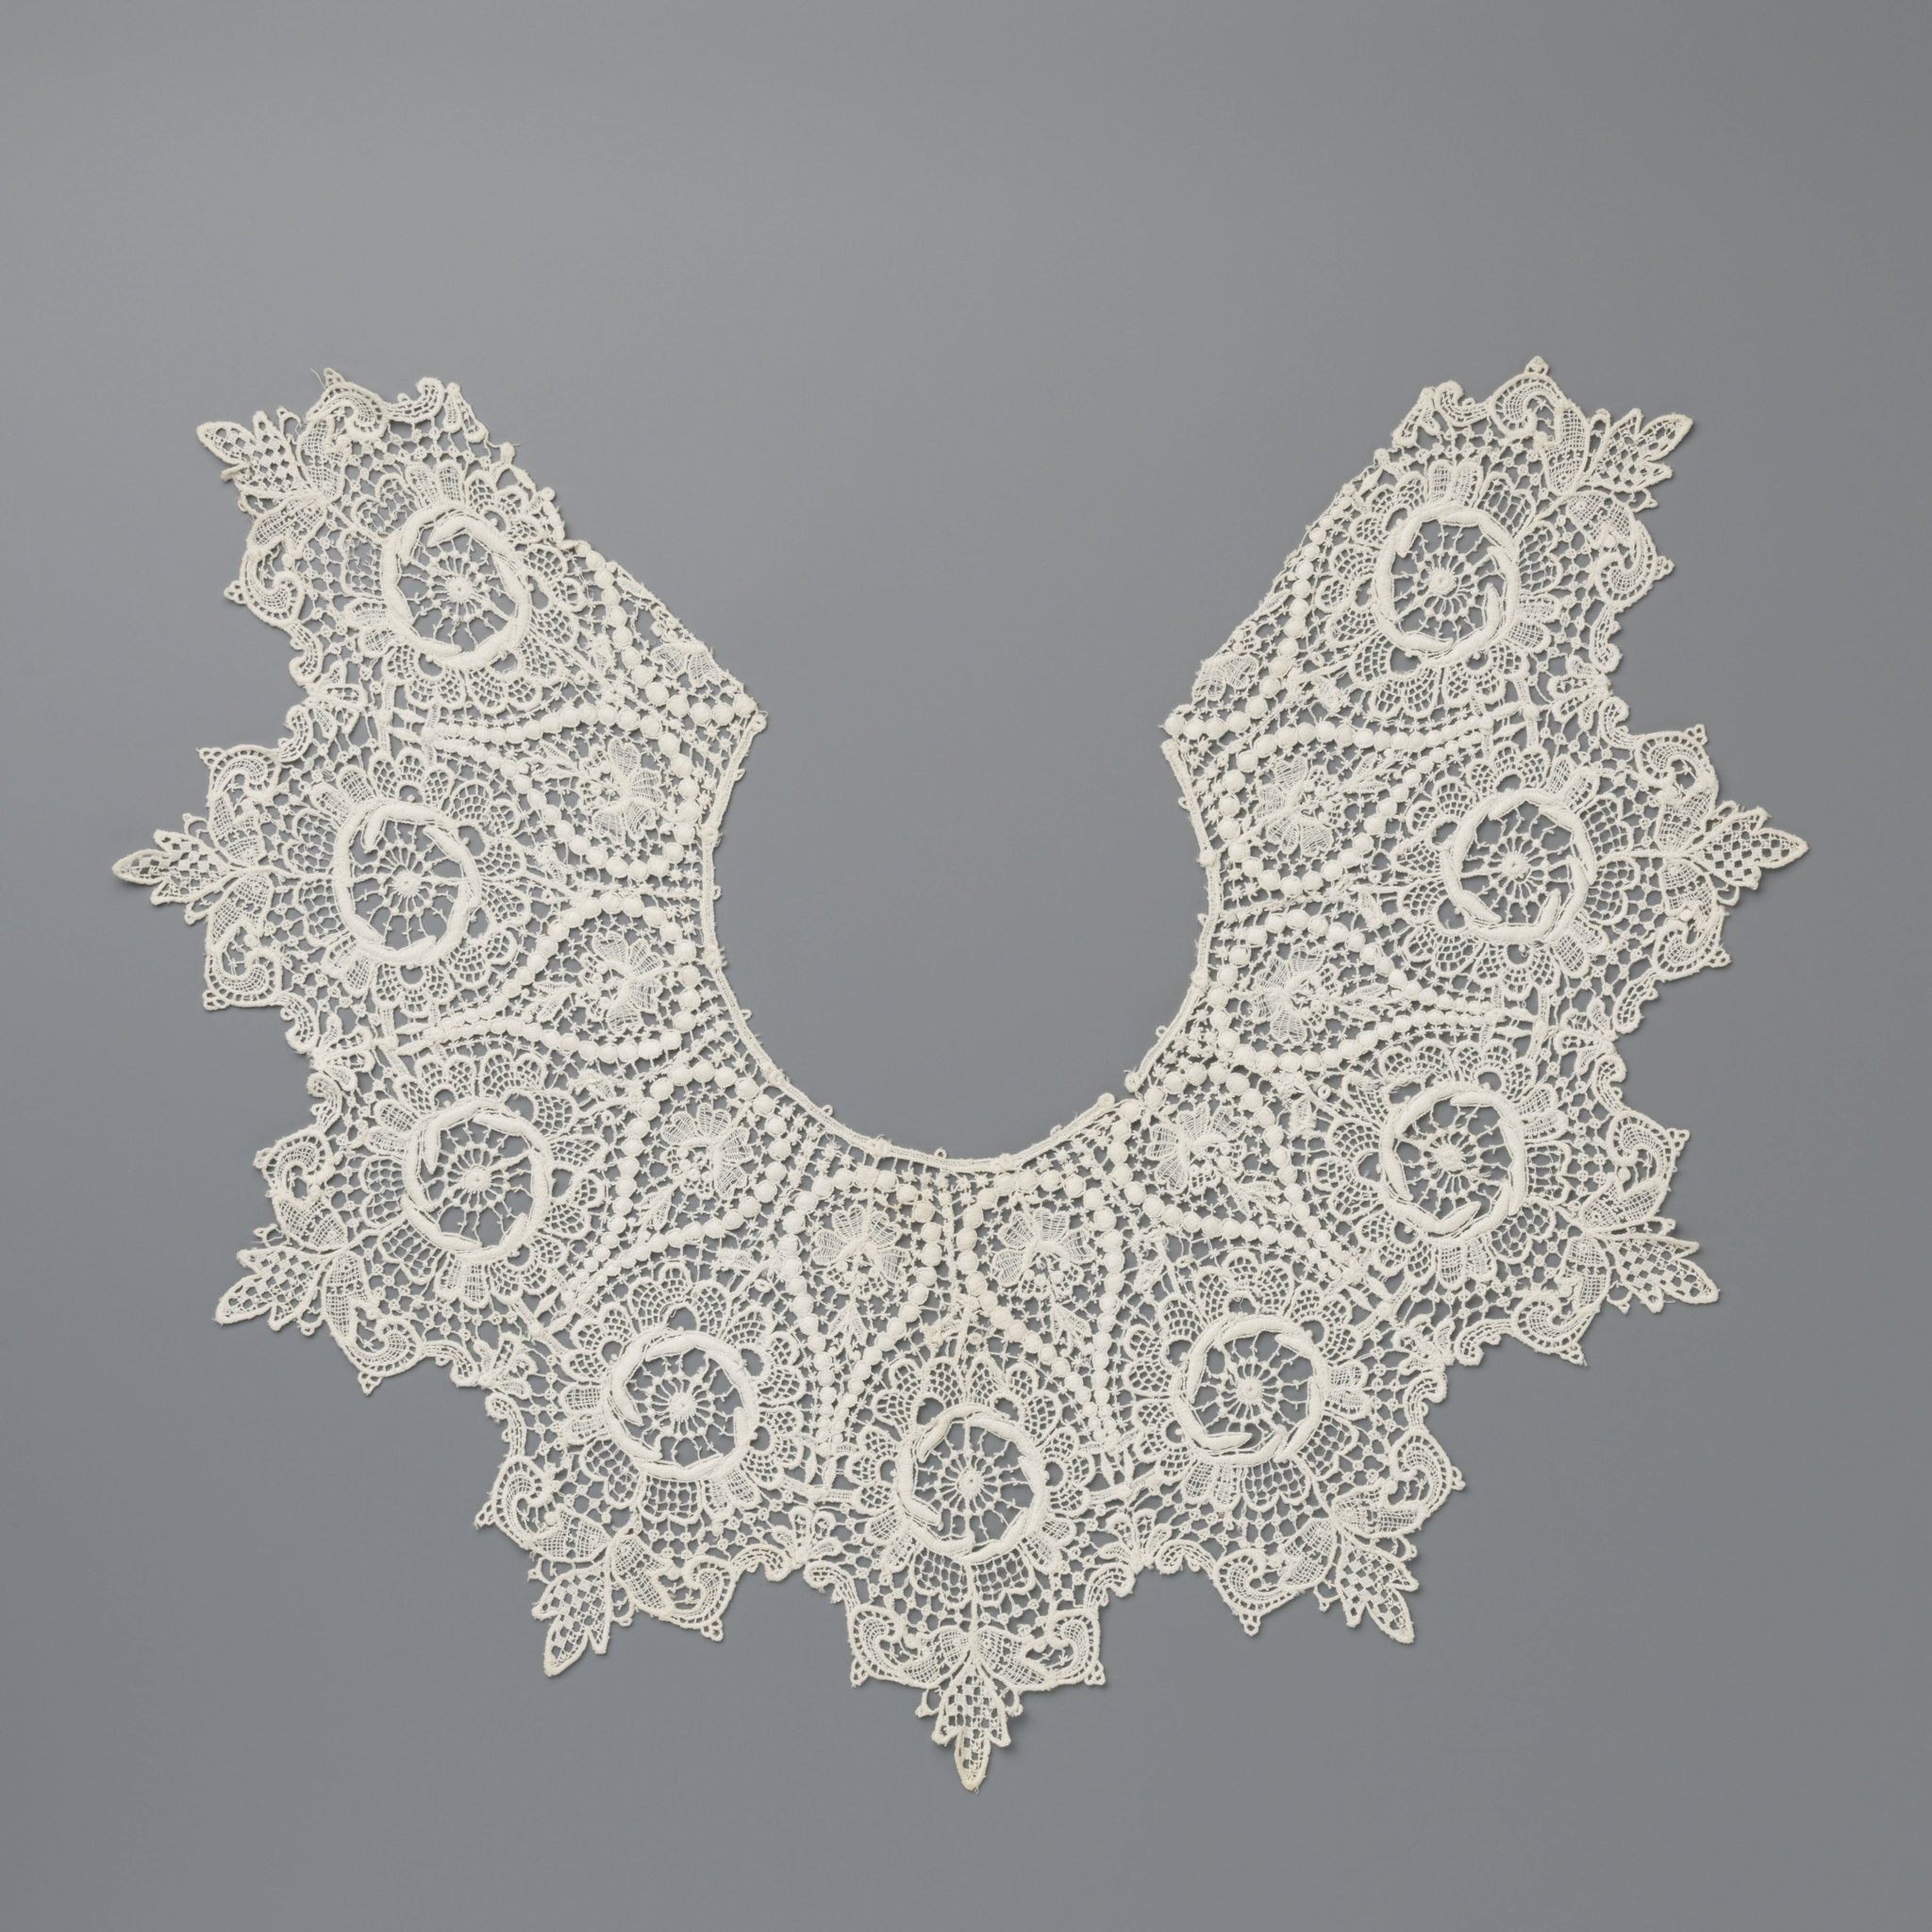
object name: collar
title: Kraag van machinale kant met negen cirkelvormige bloemen tussen tien rozen in omgekeerde druppels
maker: Anonymous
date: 1910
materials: cotton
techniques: lace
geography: switzerland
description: Kraag van machinale kant: etskant, imitatie van naaldkant. De brede kraag met negen schulpen vormt tweederde van een cirkel. Langs een smal bandje aan de binnenzijde van de cirkel liggen tien druppels - de eerste en de laatste gehalveerd - die met hun puntige uiteinden straalsgewijs naar buiten wijzen. Tussen de punten staan negen cirkelvormige bloemen, waaraan drie blaadjes tussen vier c-voluten hangen. Deze bloemen vormen met hun aanhangsels de grote schulpenrand. De contouren van de druppels zijn gemaakt met aaneengeschakelde dikke bolletjes. De contouren van de grote cirkelvormige bloemharten zijn gemaakt van zes, elkaar overlappende dikke cordons, die gefestonneerd lijken. Ook de overige contouren rond de motieven lijken gefestonneerd. De motieven zijn met elkaar verbonden door spijlen, voorzien van picots of raderpicots. In de motieven zijn verschillende siergronden toegepast.